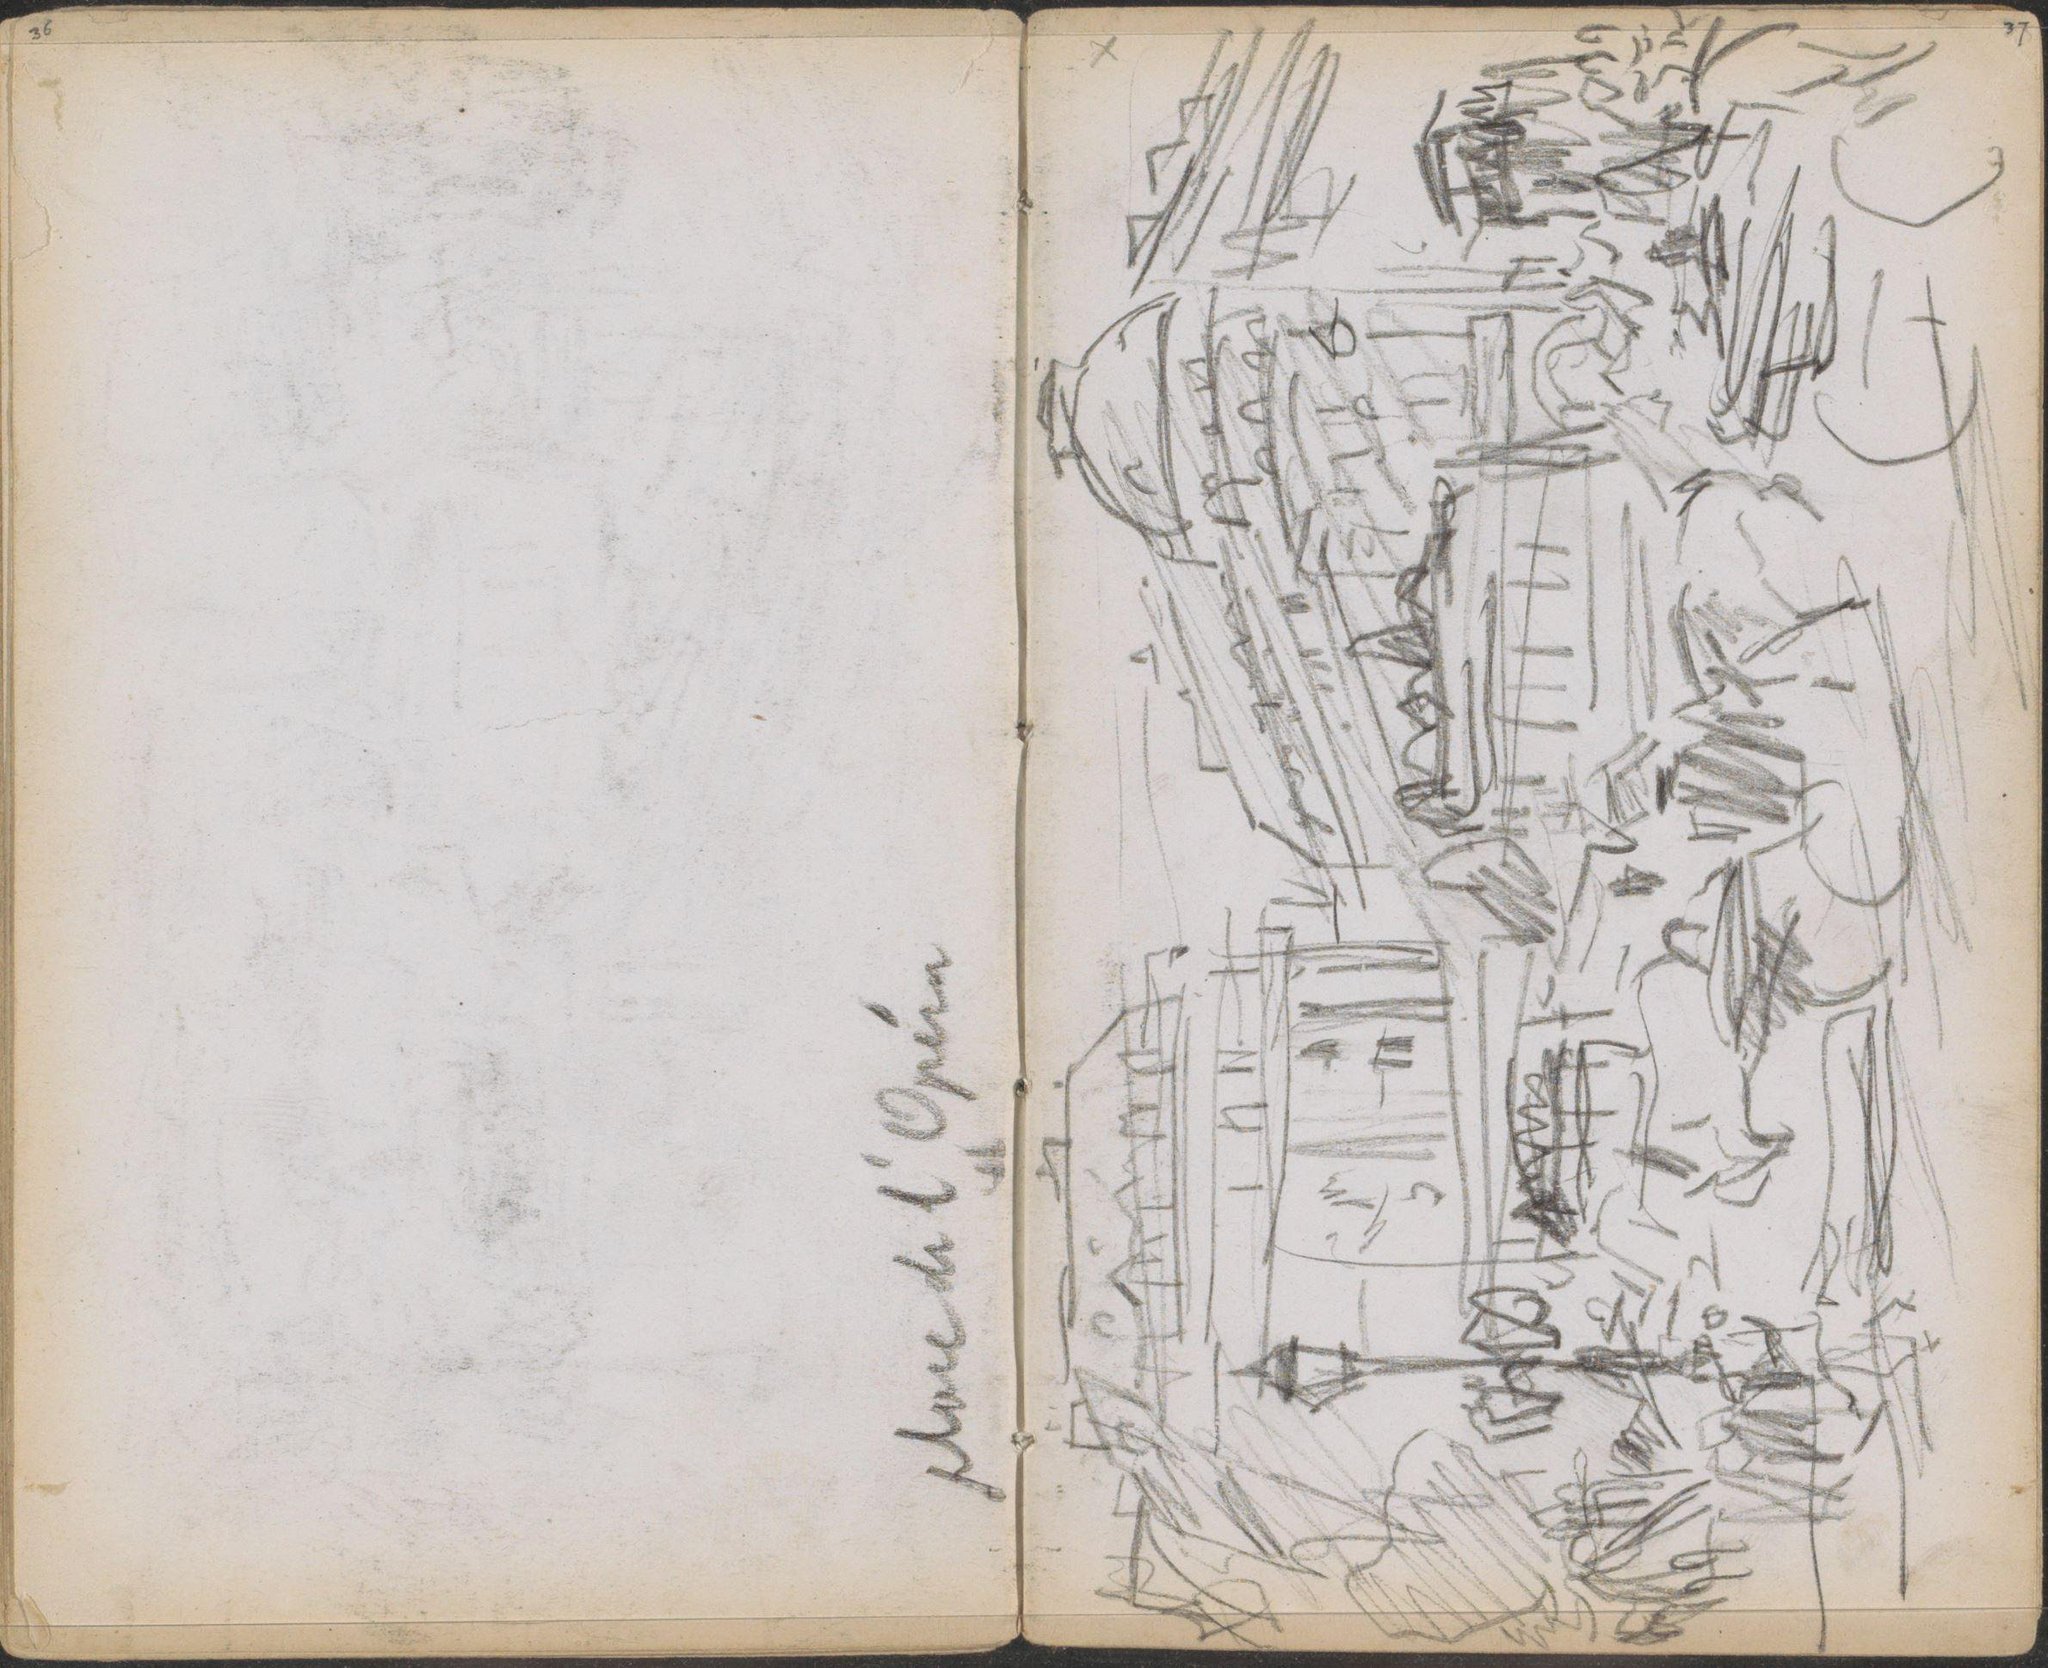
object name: sketchbook leaf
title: Place de l'Opéra, Parijs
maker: marius bauer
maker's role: draughtsman, print maker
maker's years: 1867-1932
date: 1810-1891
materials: chalk, paper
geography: paris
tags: square, place, circus, etc., street lighting, street (+ city(-scape) with figures, staffage)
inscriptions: annotation: ‘place de l'Opéra’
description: Gezicht op het kruispunt voor het operagebouw van Charles Garnier met verkeer. Pagina 36 en 37 uit een schetsboek met 35 bladen.